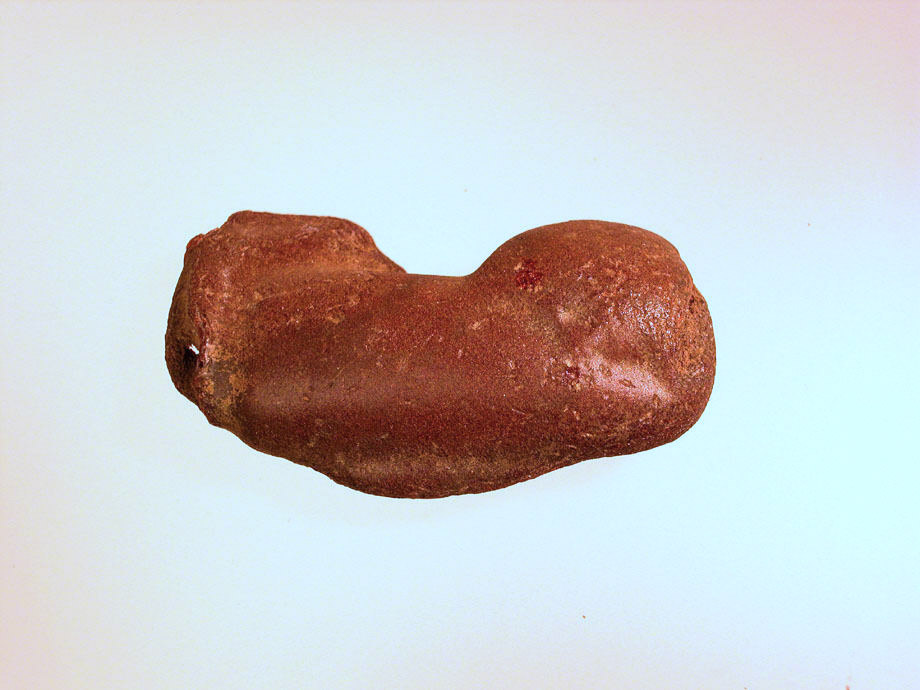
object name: head of acheloos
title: Pendant: Head of Acheloos?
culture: italic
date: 500-401 BCE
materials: amber